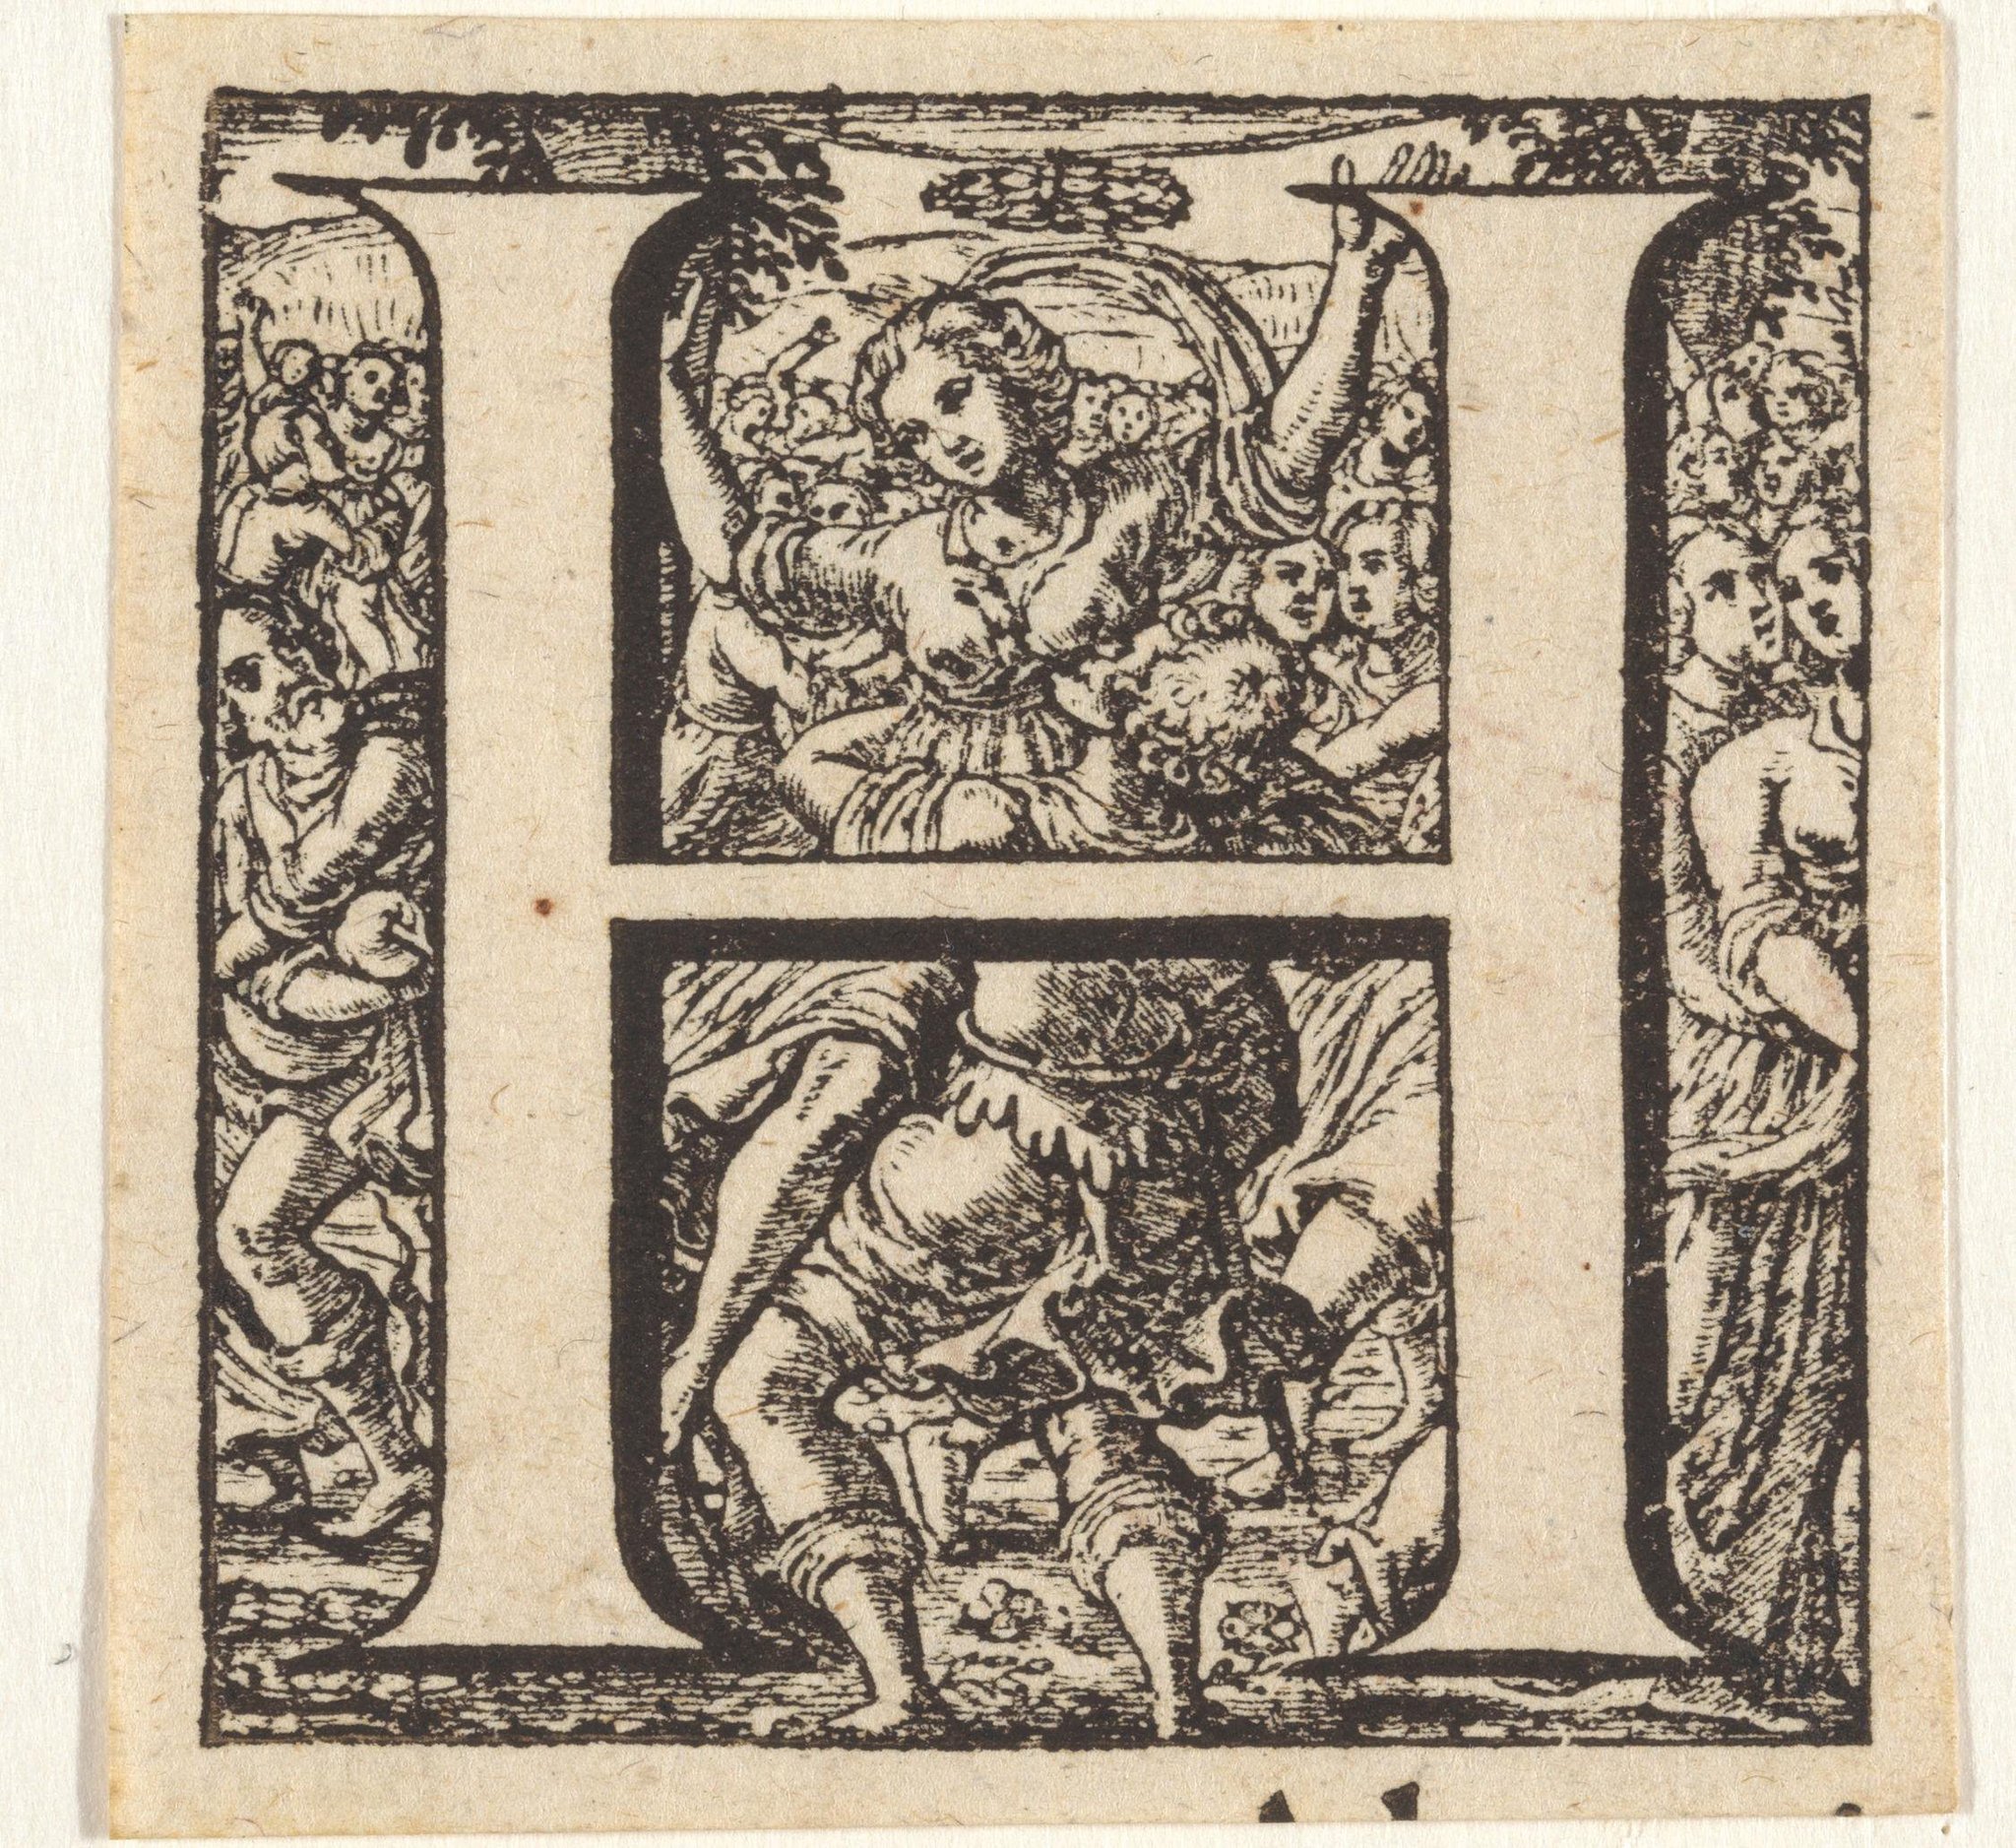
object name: print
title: Letter H in een omlijsting met een voorstelling van meerdere verliefde stellen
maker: Anonymous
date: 1600-1699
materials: paper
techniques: woodcut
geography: netherlands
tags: fancy letters, couple of lovers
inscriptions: collector's mark: Lugt 240